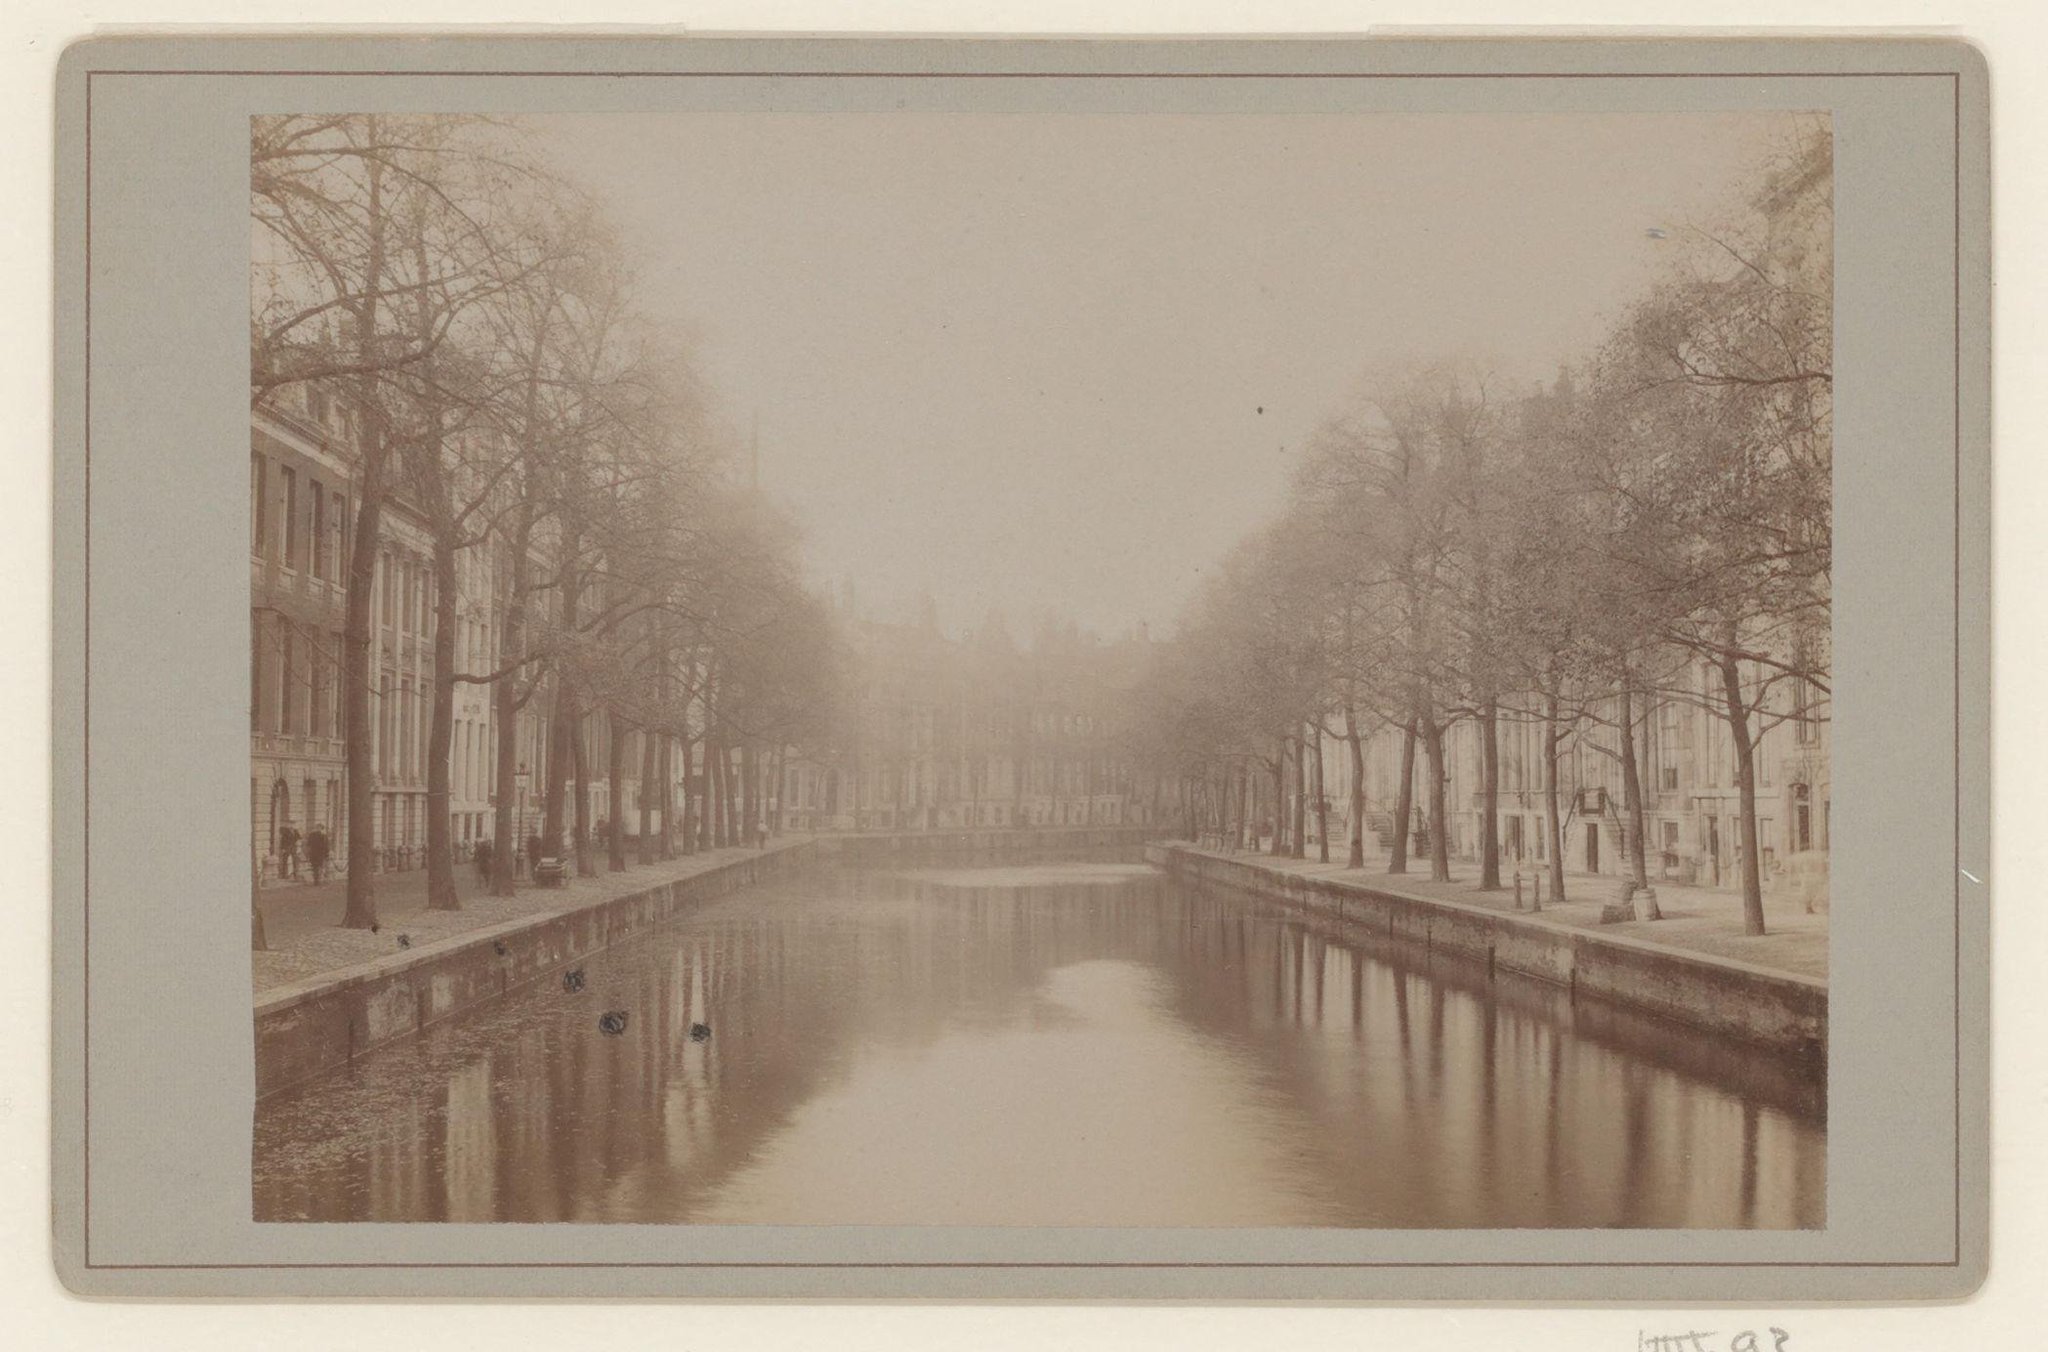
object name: cabinet photograph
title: Gezicht op de Herengracht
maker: Anonymous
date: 1850-1915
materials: cardboard, paper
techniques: albumen print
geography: amsterdam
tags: city-view in general; 'veduta', canal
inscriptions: collector's mark: ‘8,93’ Lugt 1641b, inscription: ‘No 18 Bocht Heerengr.’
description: Onderwerpsrubriek binnen de Atlas Amsterdam: Haarlemmerplein, Halvemaansteeg, Handboogstraat, Handelskade, Haringpakkerij, Hartenstraat, Hasseltsteeg (Dirk van), Heerengracht.